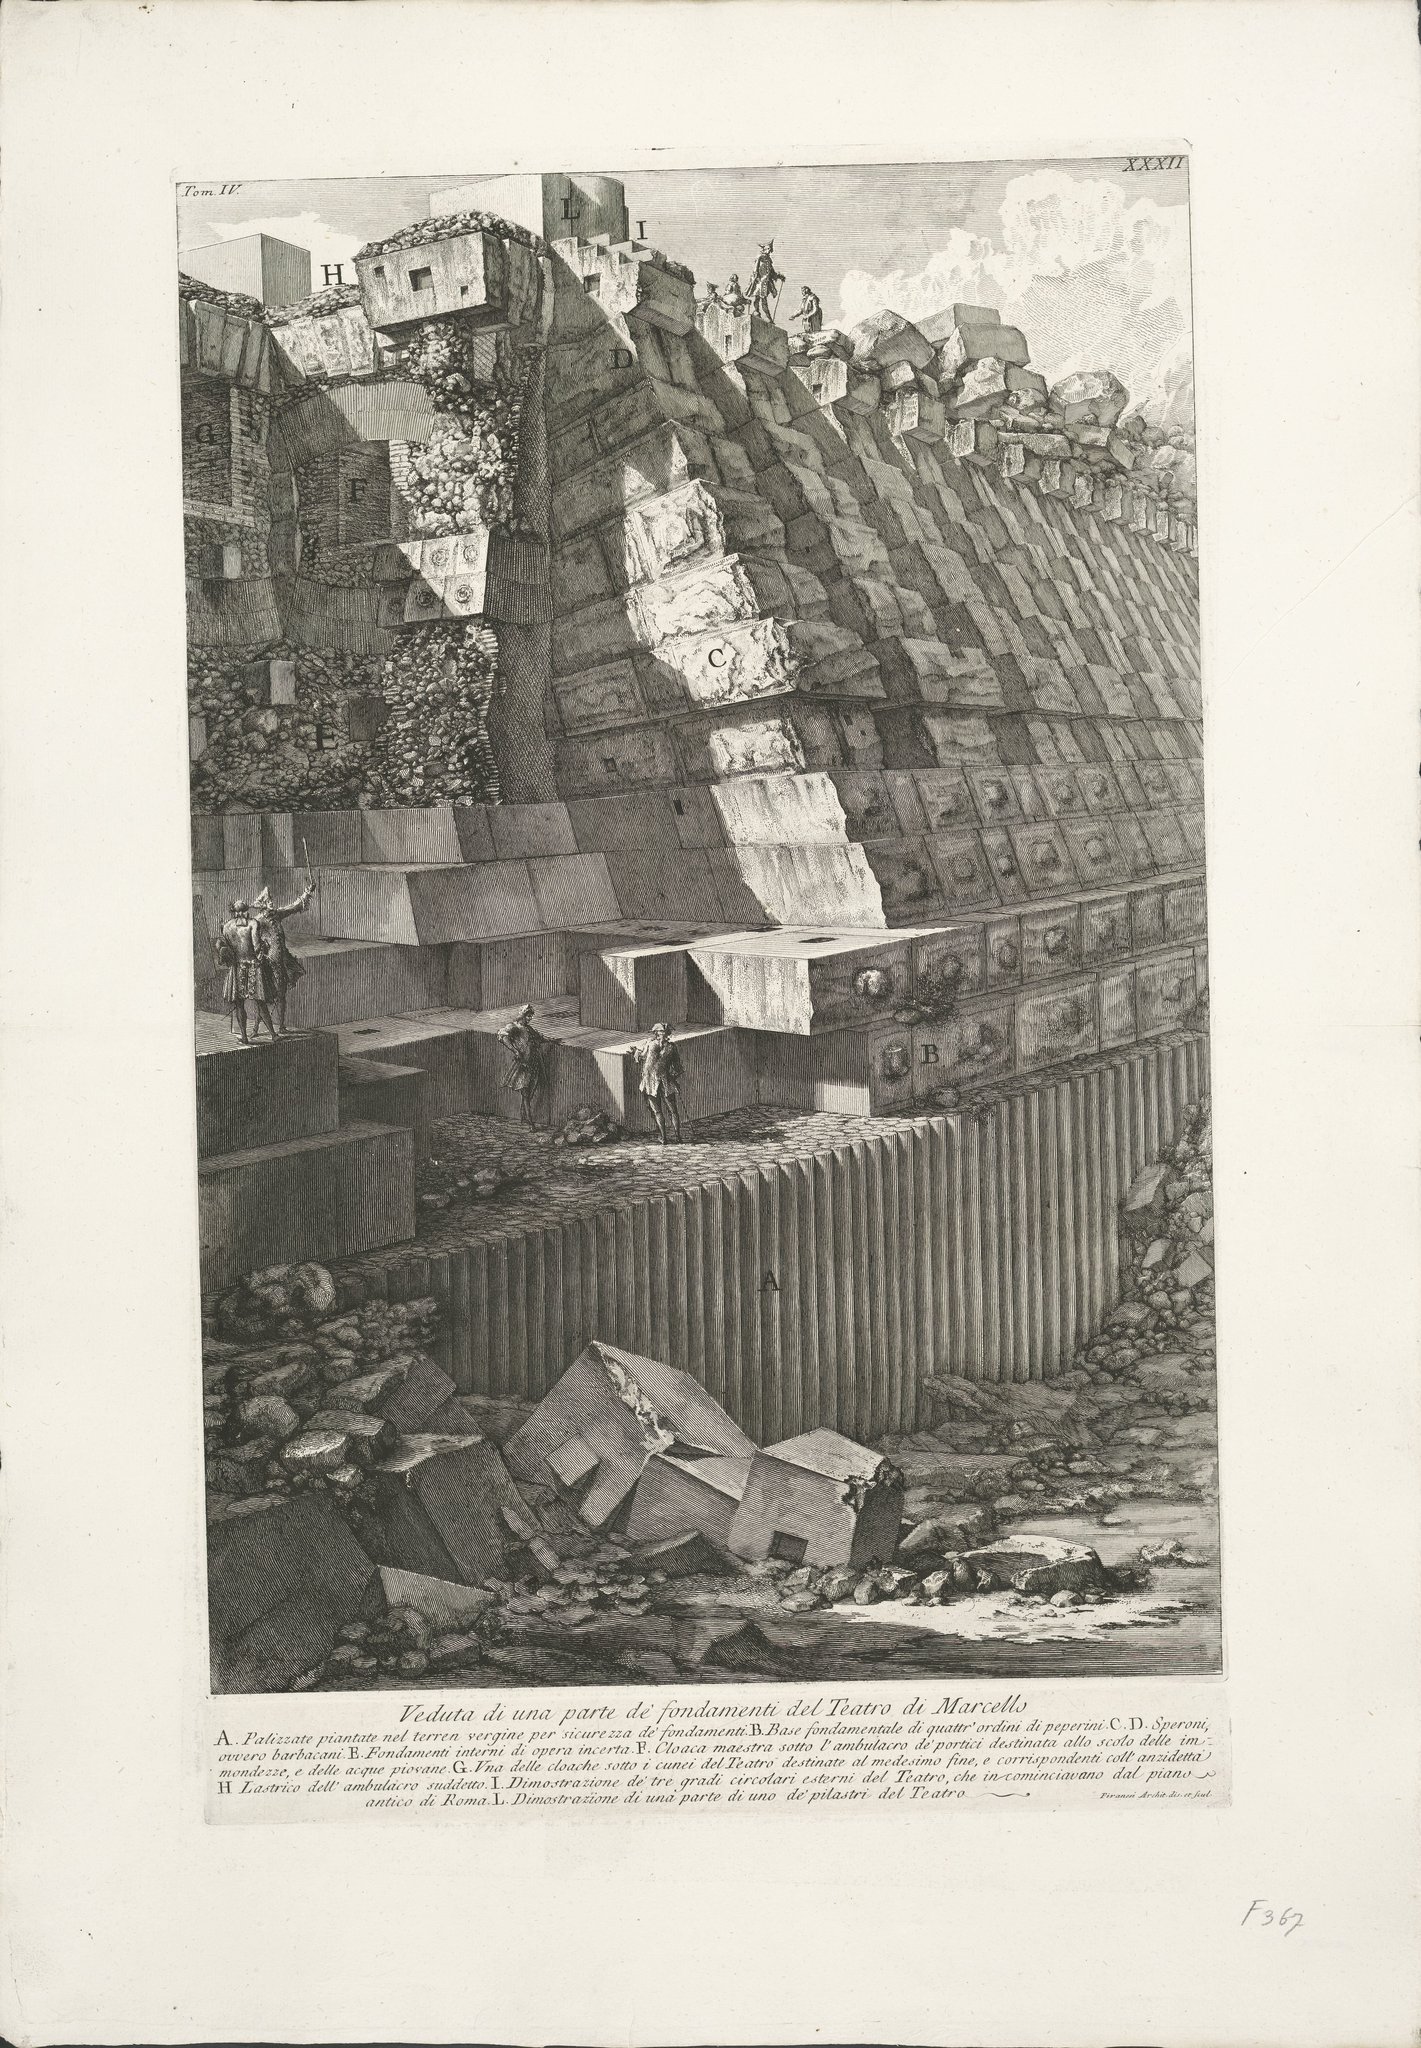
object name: print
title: Le Antichità Romane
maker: giovanni battista piranesi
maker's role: designer, draughtsman, print maker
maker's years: 1720-1778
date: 1756-1757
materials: paper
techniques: etching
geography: rome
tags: ruin of a building ~ architecture, theatre (building), theatre (building) - aa - open-air performances, rome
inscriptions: collector's mark: Lugt 2228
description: Deze prent maakt deel uit van de serie 'Le Antichità Romane'. Piranesi deed meer dan acht jaar voorstudie voor deze 250 platen tellende serie die in vier volumes werd uitgegeven. Hij produceerde de prenten tussen ca. 1756 en 1757. De serie bevat ook prenten door of naar andere prentmakers, onder wie Francesco Bianchini en Girolamo Rossi.